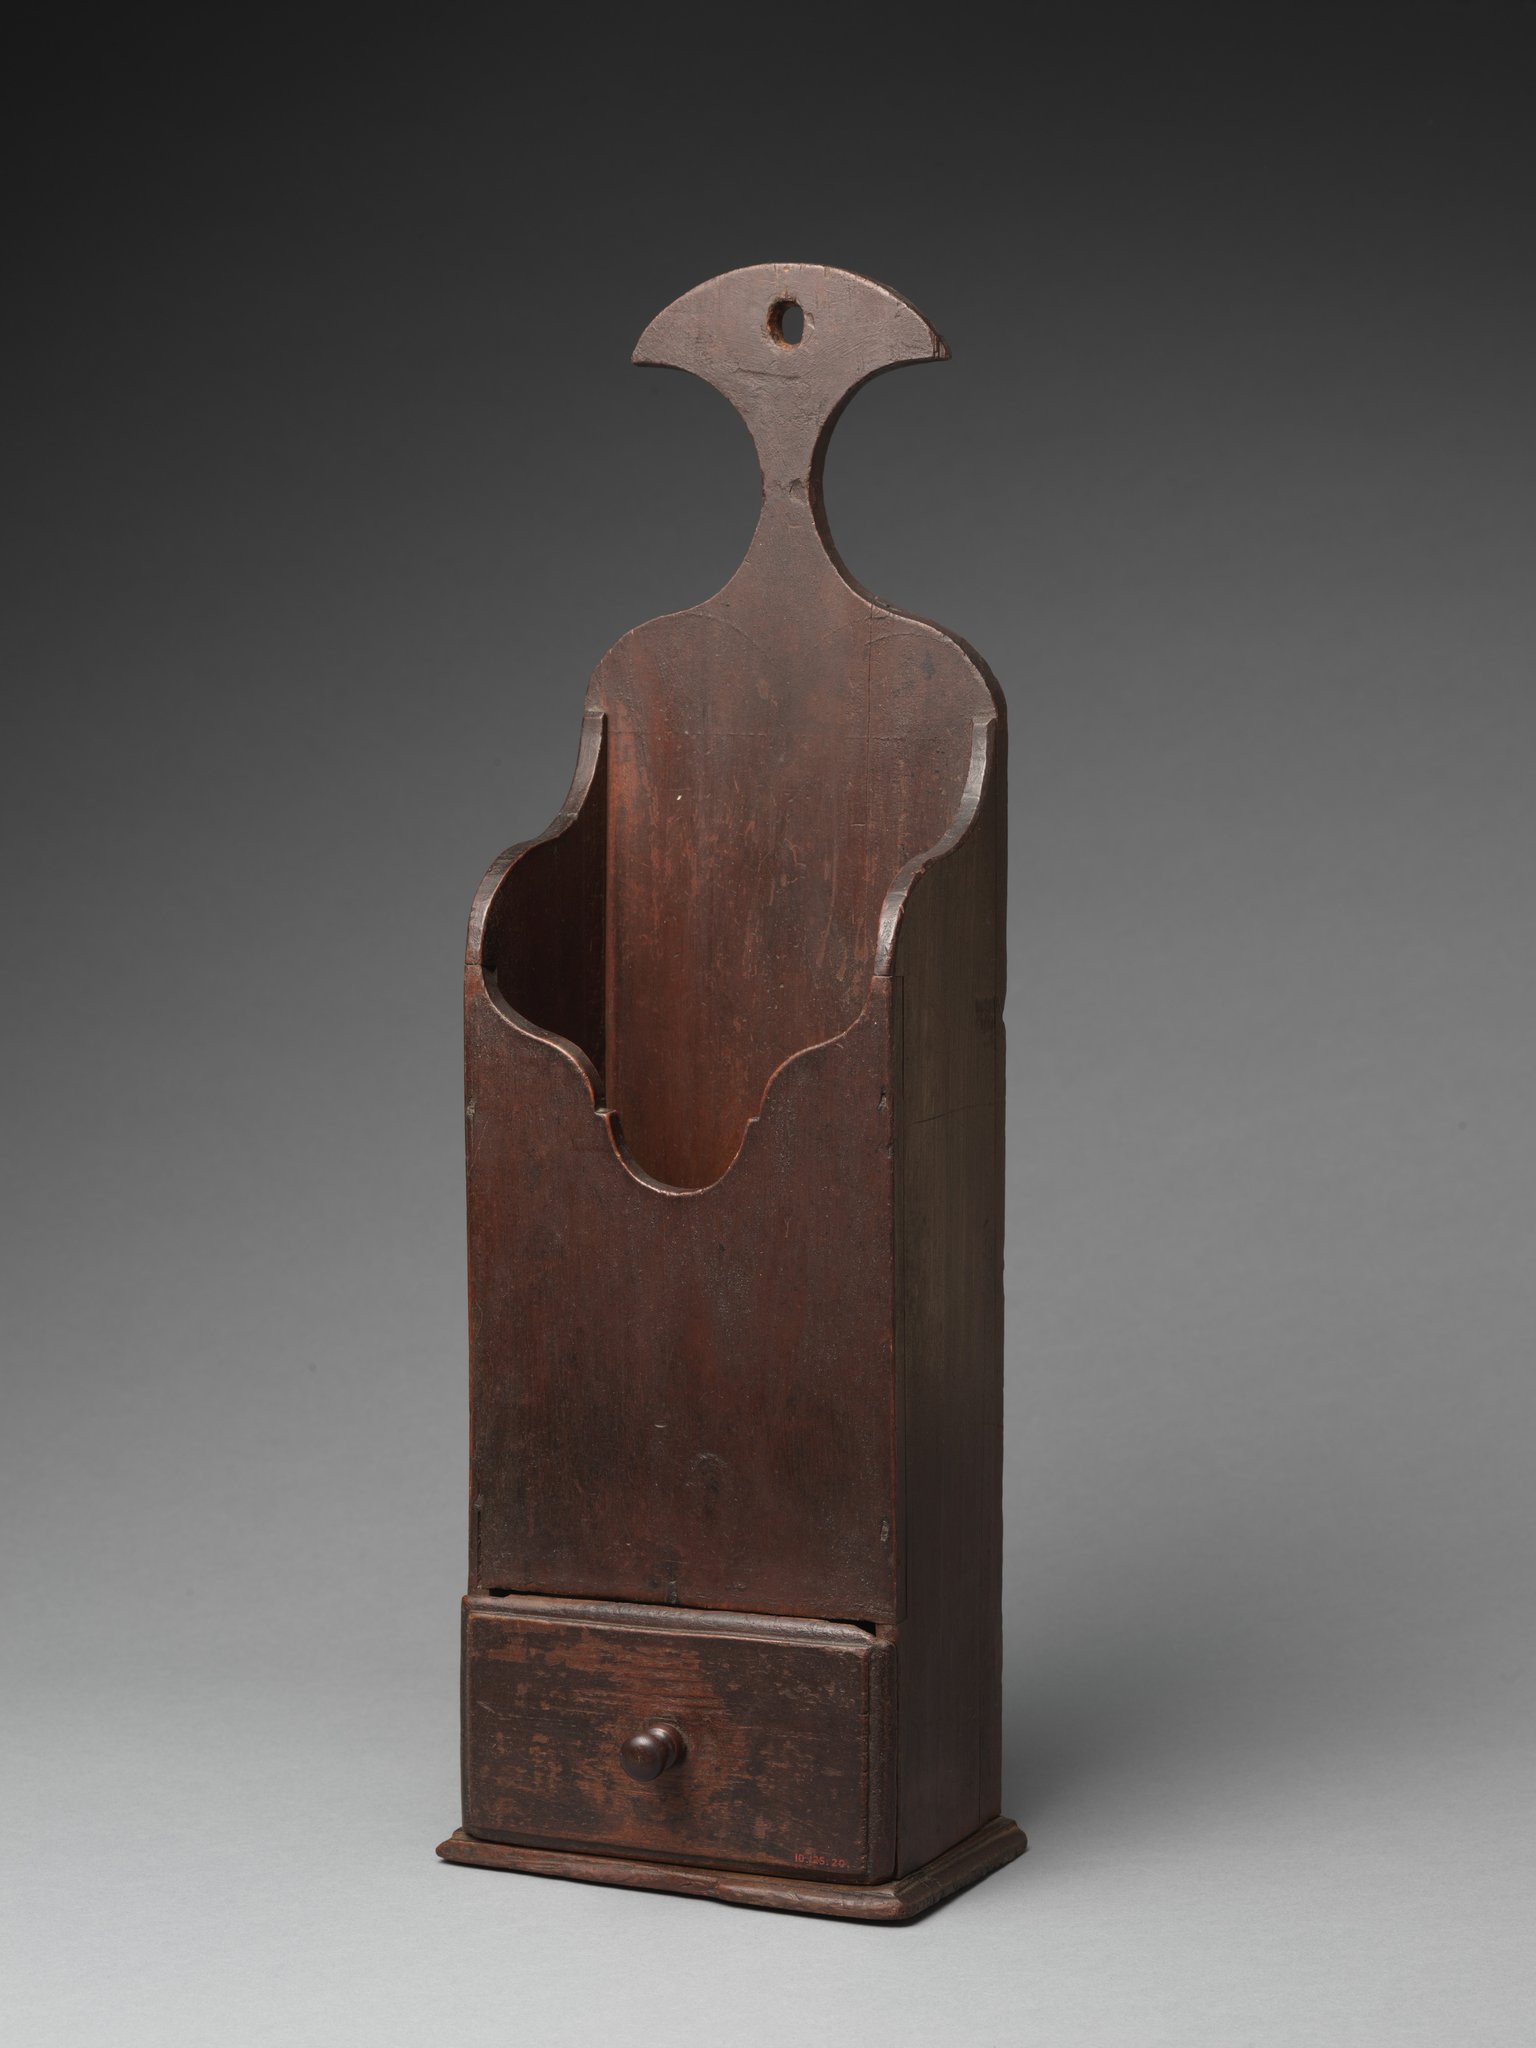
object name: pipe box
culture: american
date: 1700-1800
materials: wood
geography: united states